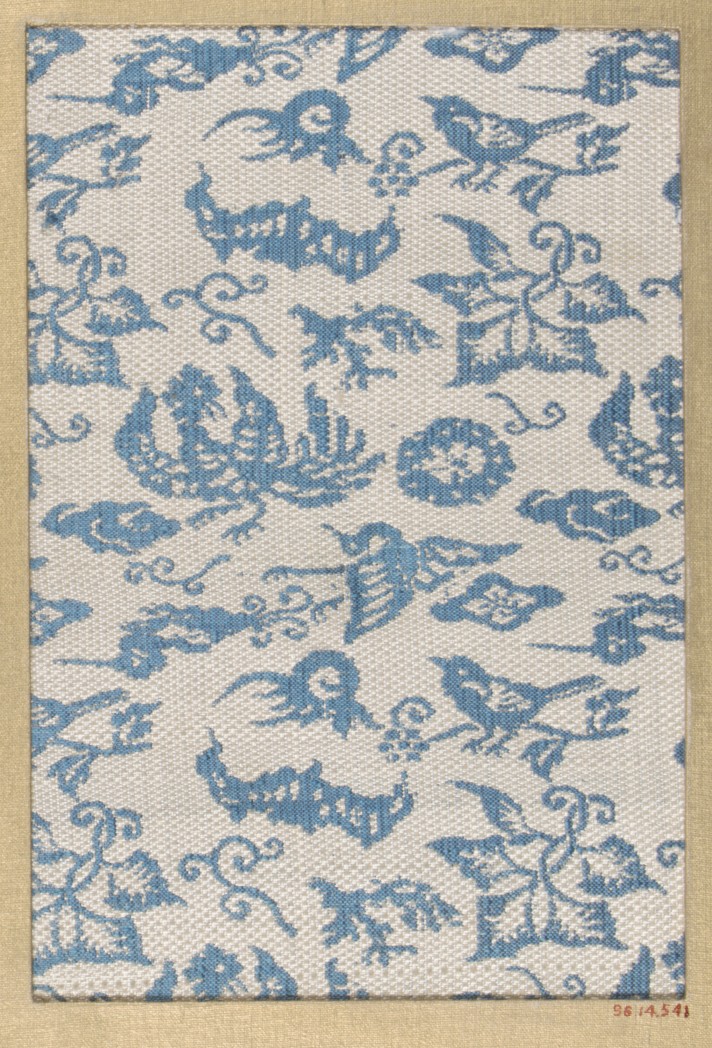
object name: piece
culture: japanese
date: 1701-1900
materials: silk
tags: birds